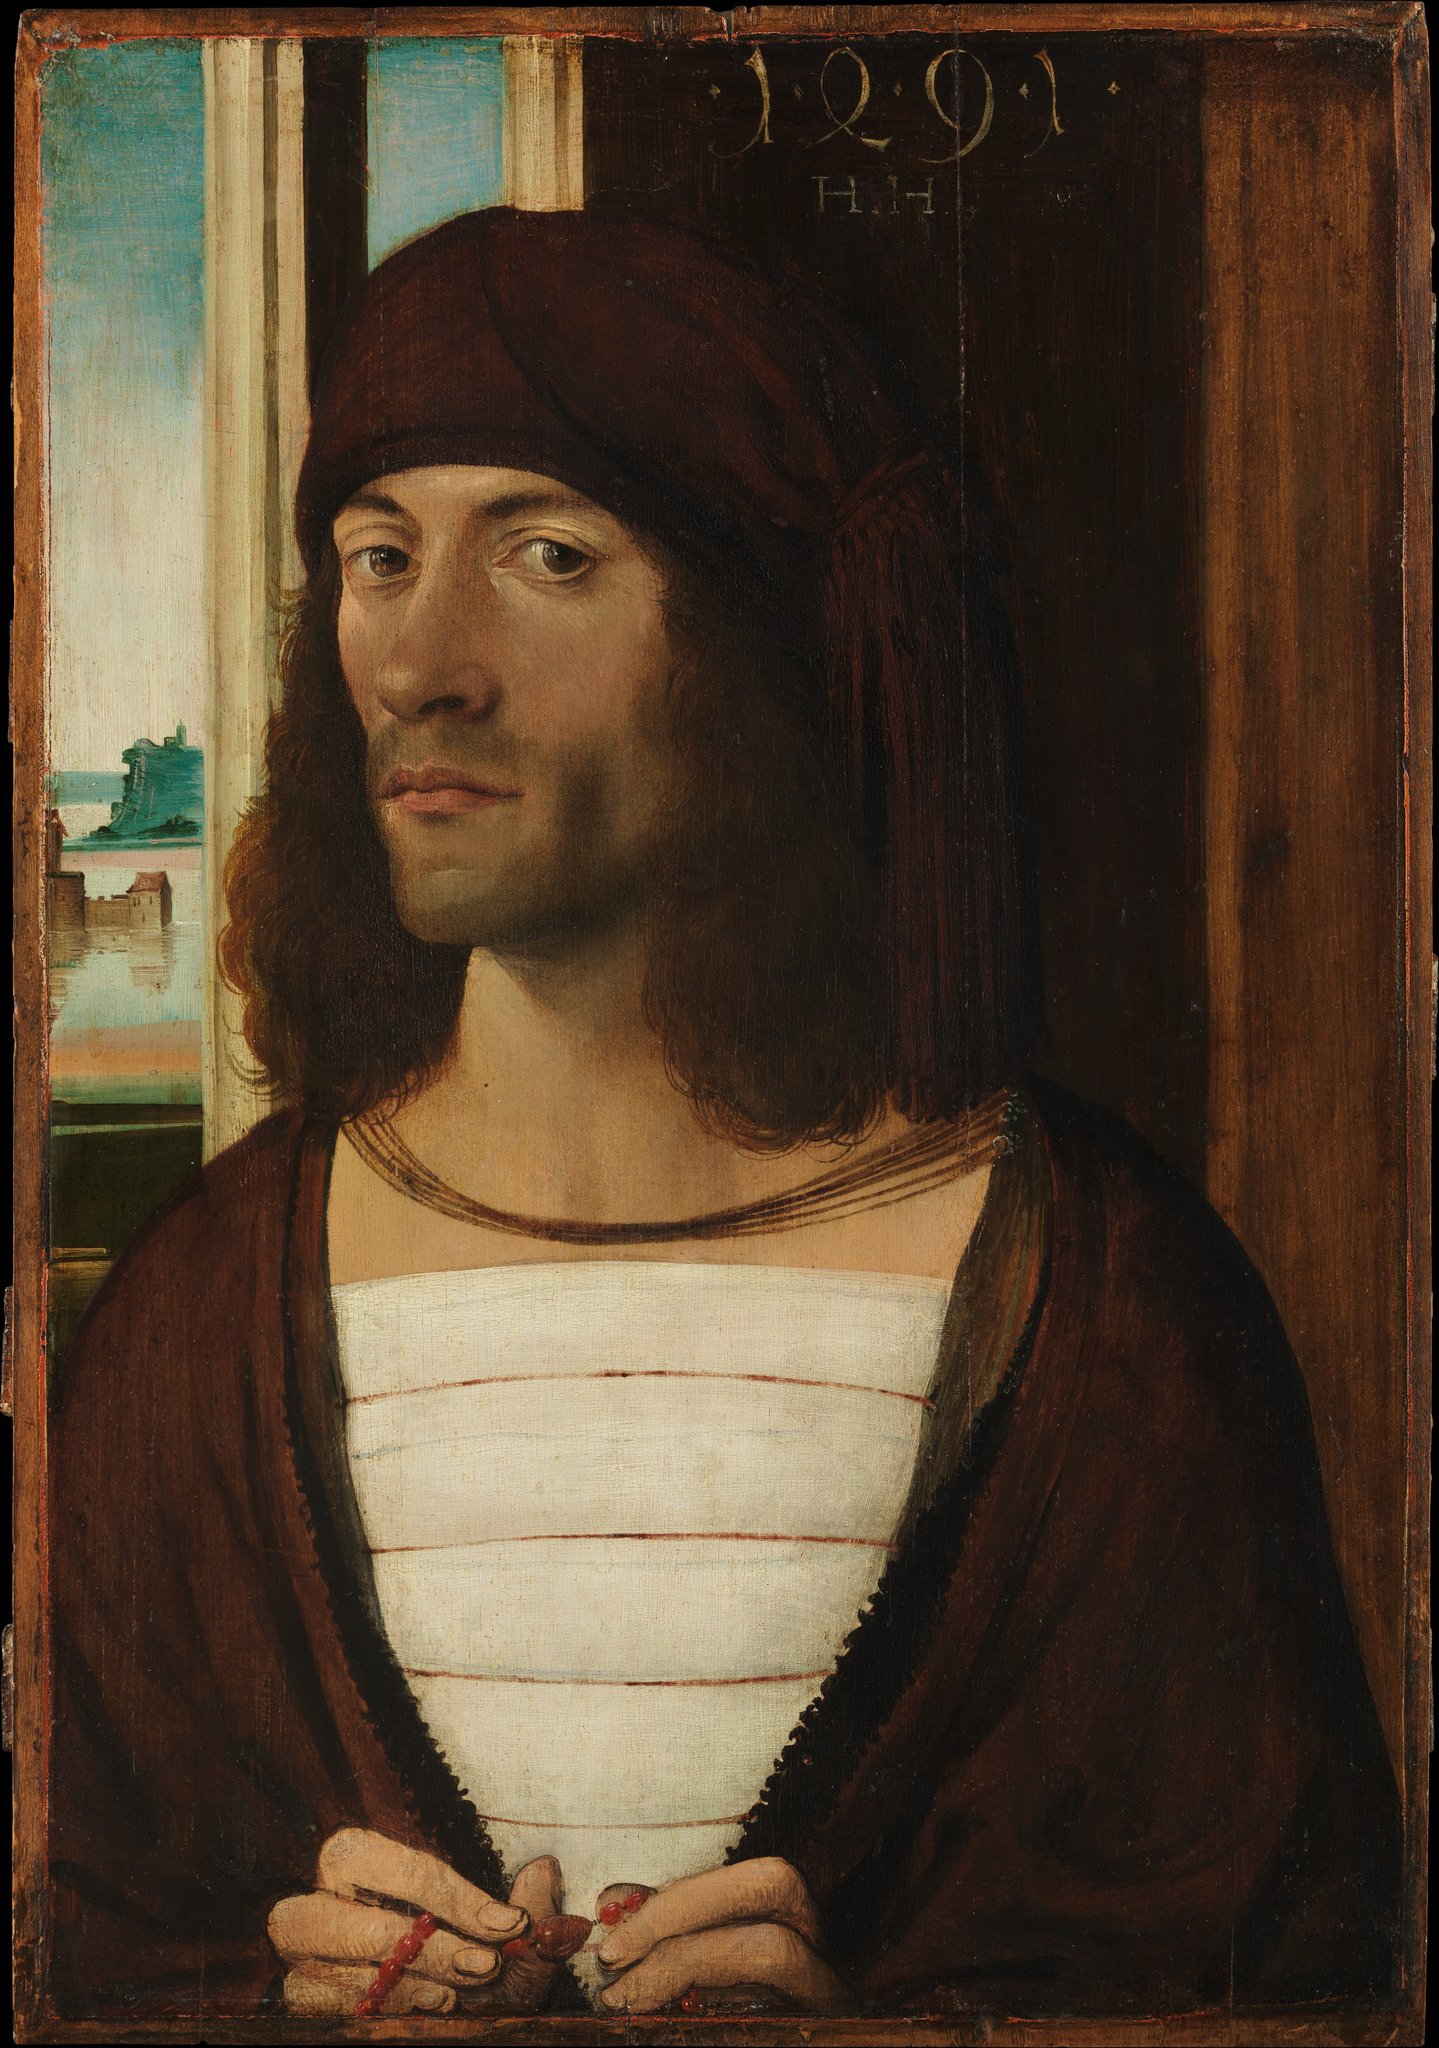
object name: painting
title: Portrait of a Man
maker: german (nuremberg) painter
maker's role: artist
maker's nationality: german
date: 1491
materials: wood, oil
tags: men,portraits